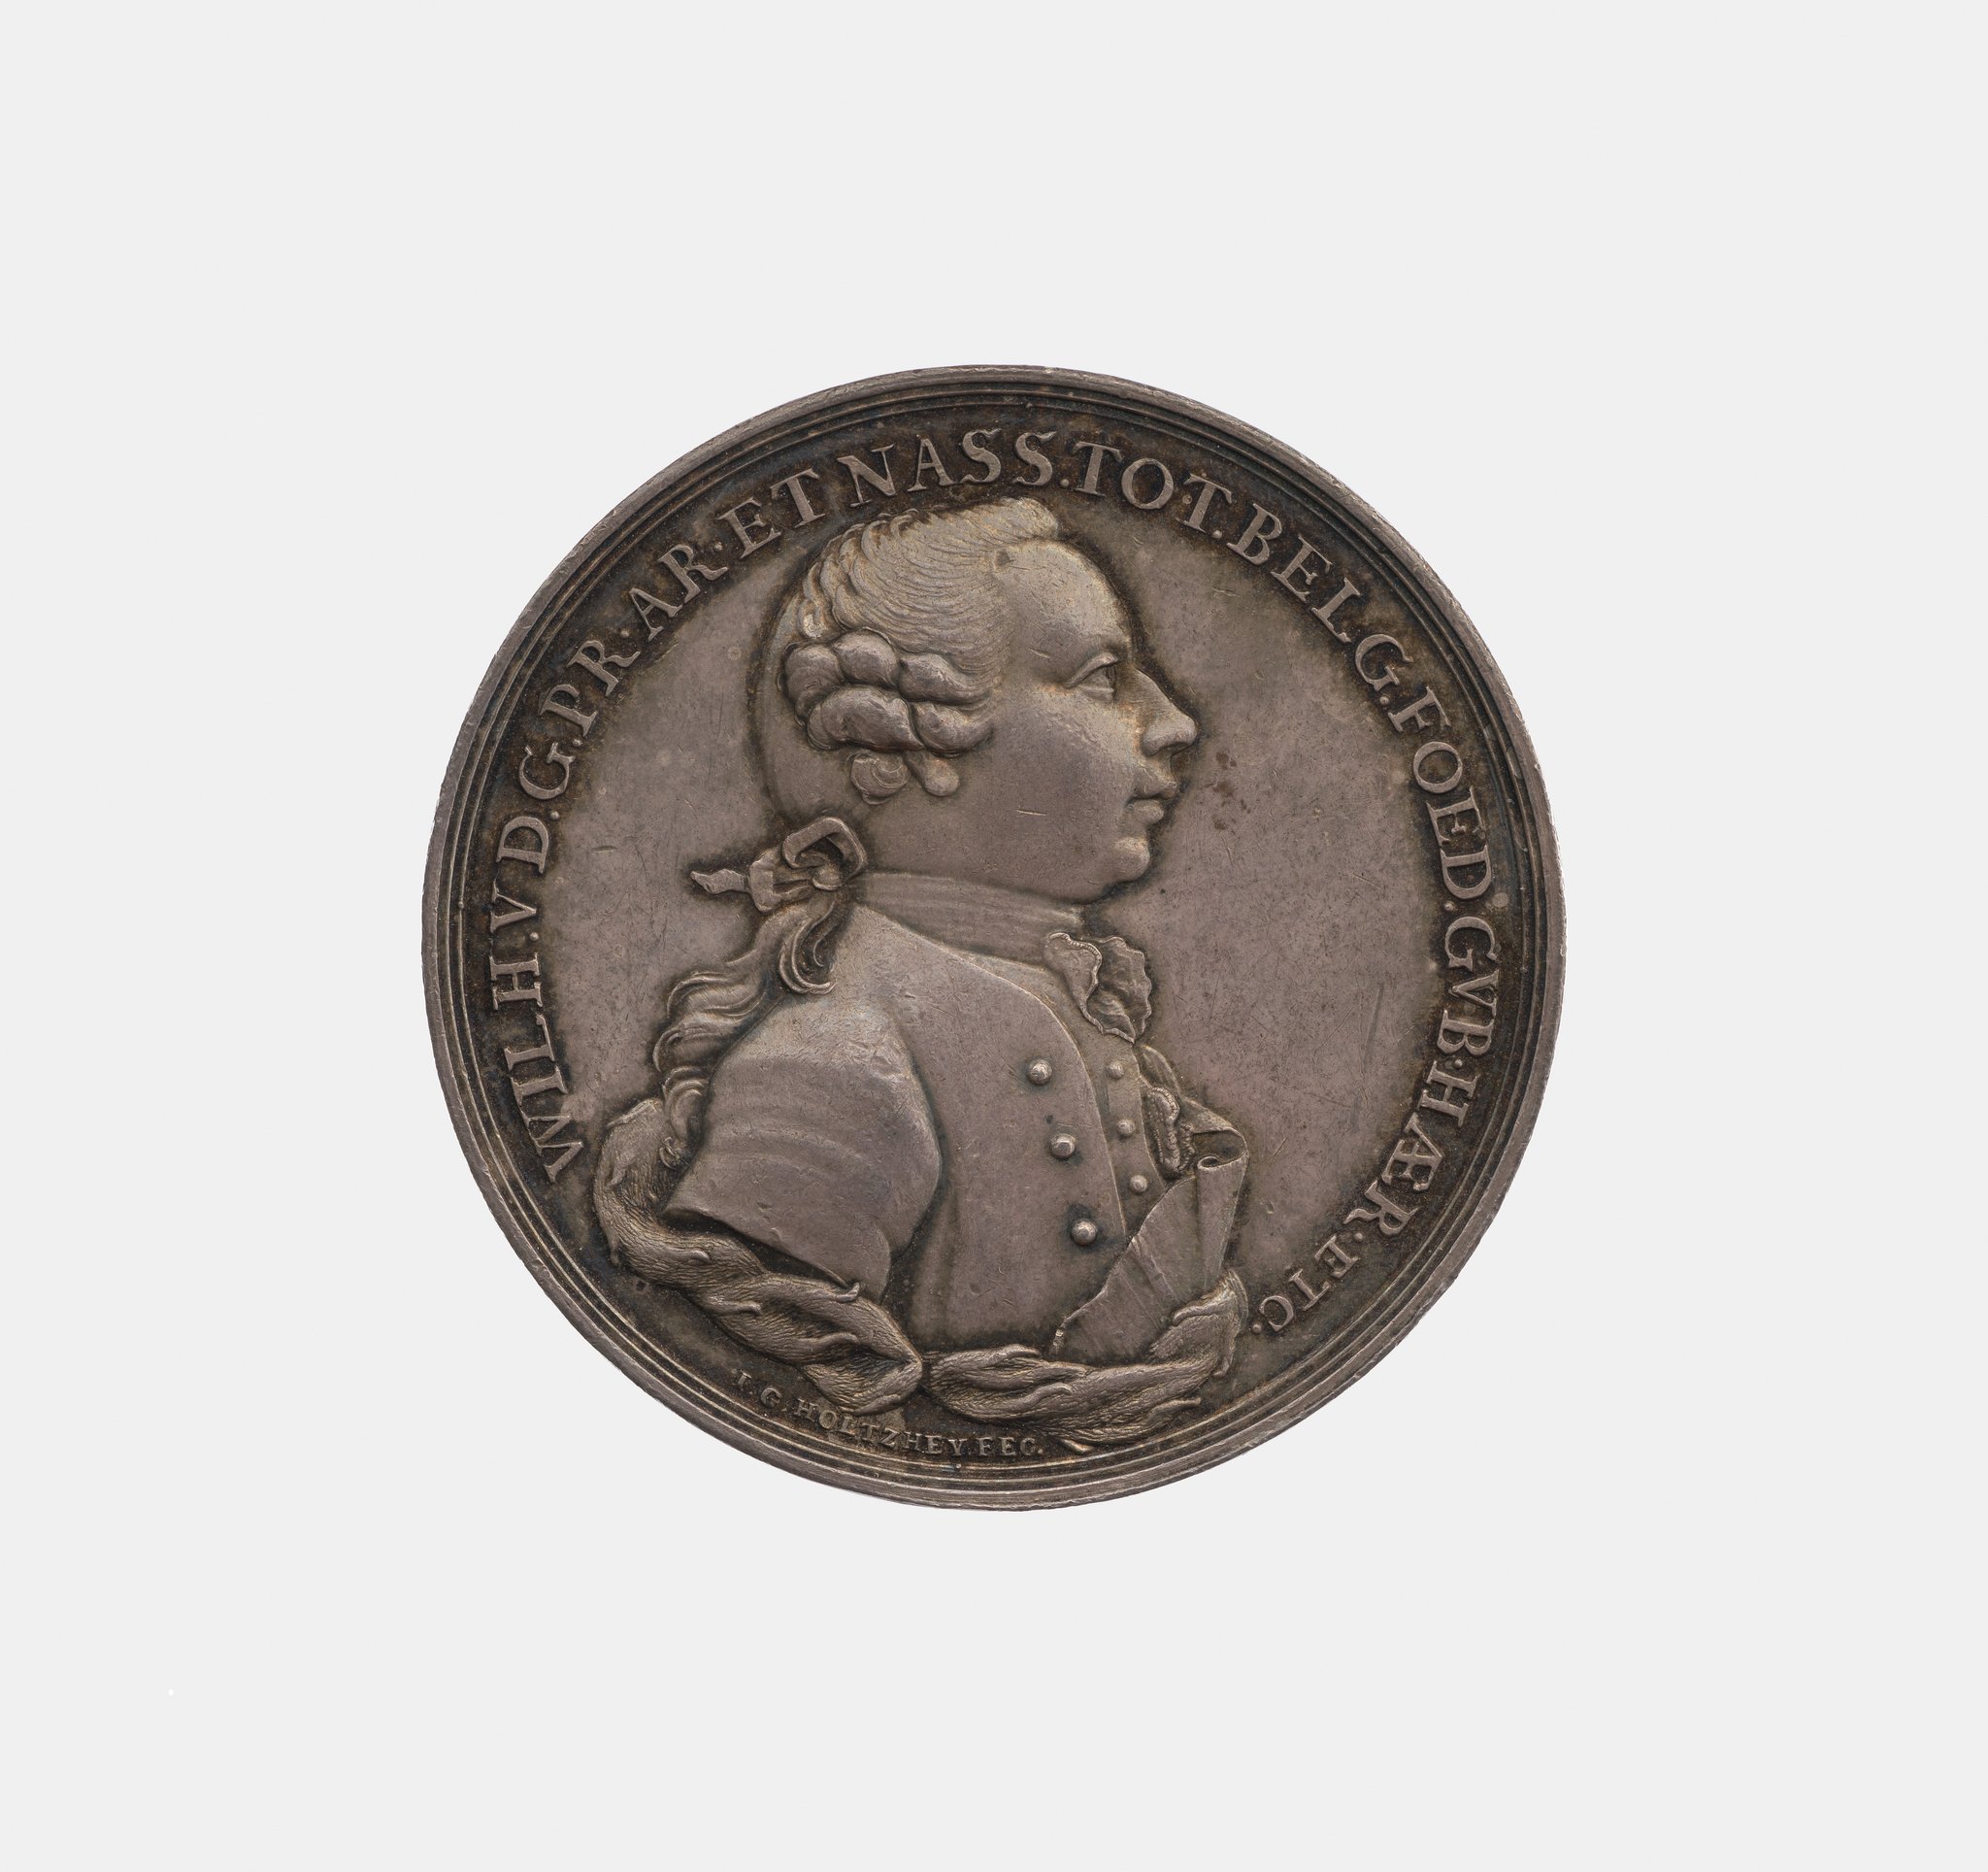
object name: medal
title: Inauguration of Willem V of Nassau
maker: johann georg holtzhey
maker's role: artist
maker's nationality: dutch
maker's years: 1729-1808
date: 1766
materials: silver